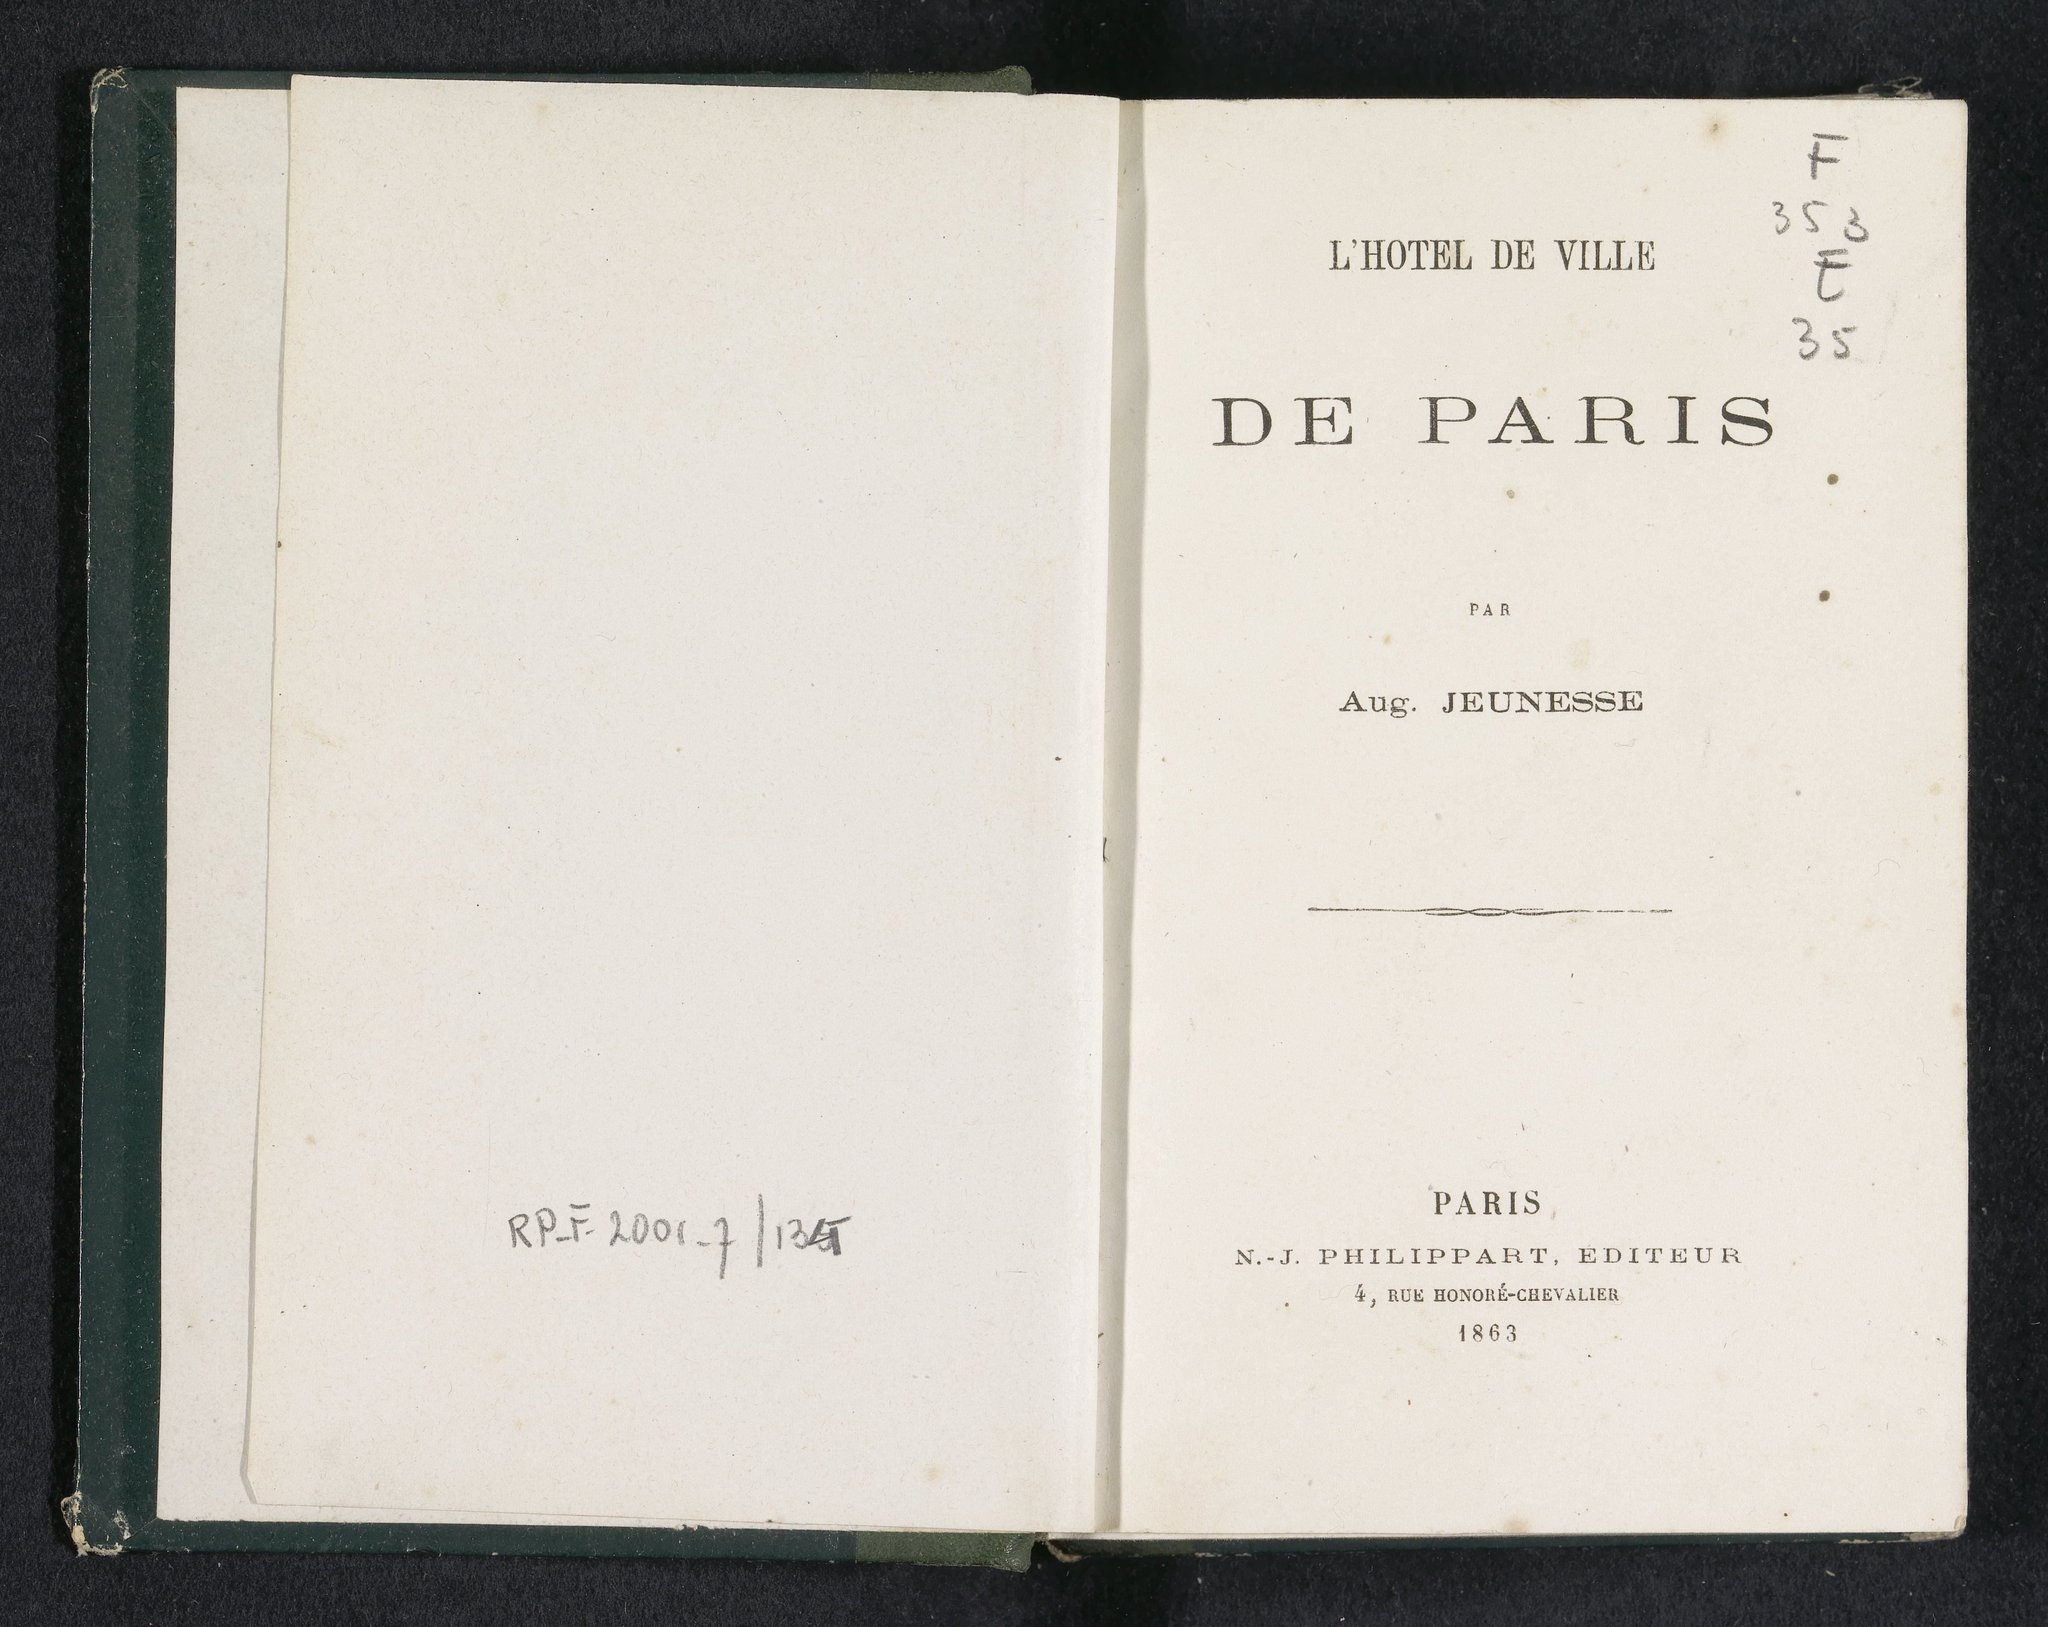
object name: book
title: Le monde photographié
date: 1863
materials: cardboard, linen, paper, photographic support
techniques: albumen print, printing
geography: paris